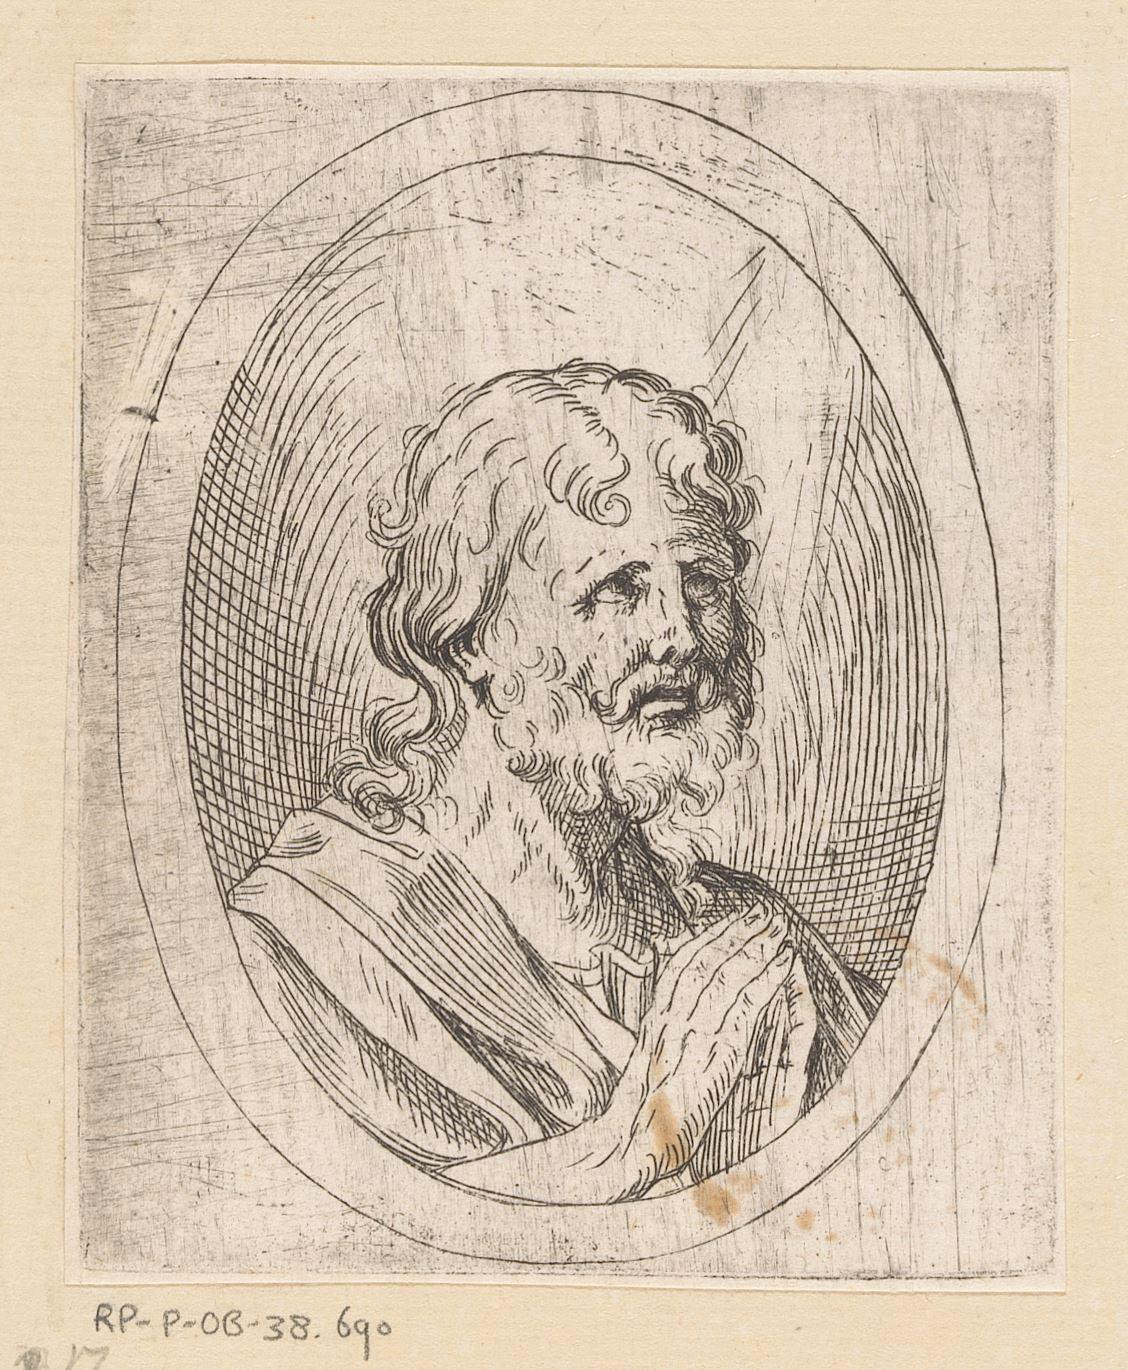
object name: print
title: Apostel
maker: Anonymous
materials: paper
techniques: etching